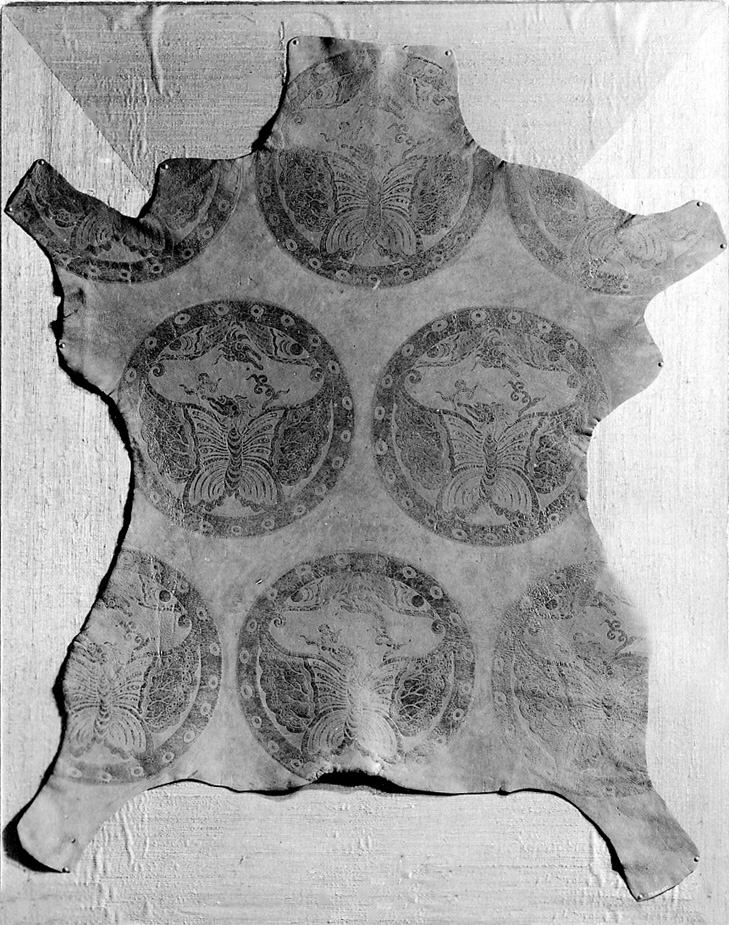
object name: panel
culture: japanese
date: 1801-1900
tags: butterflies